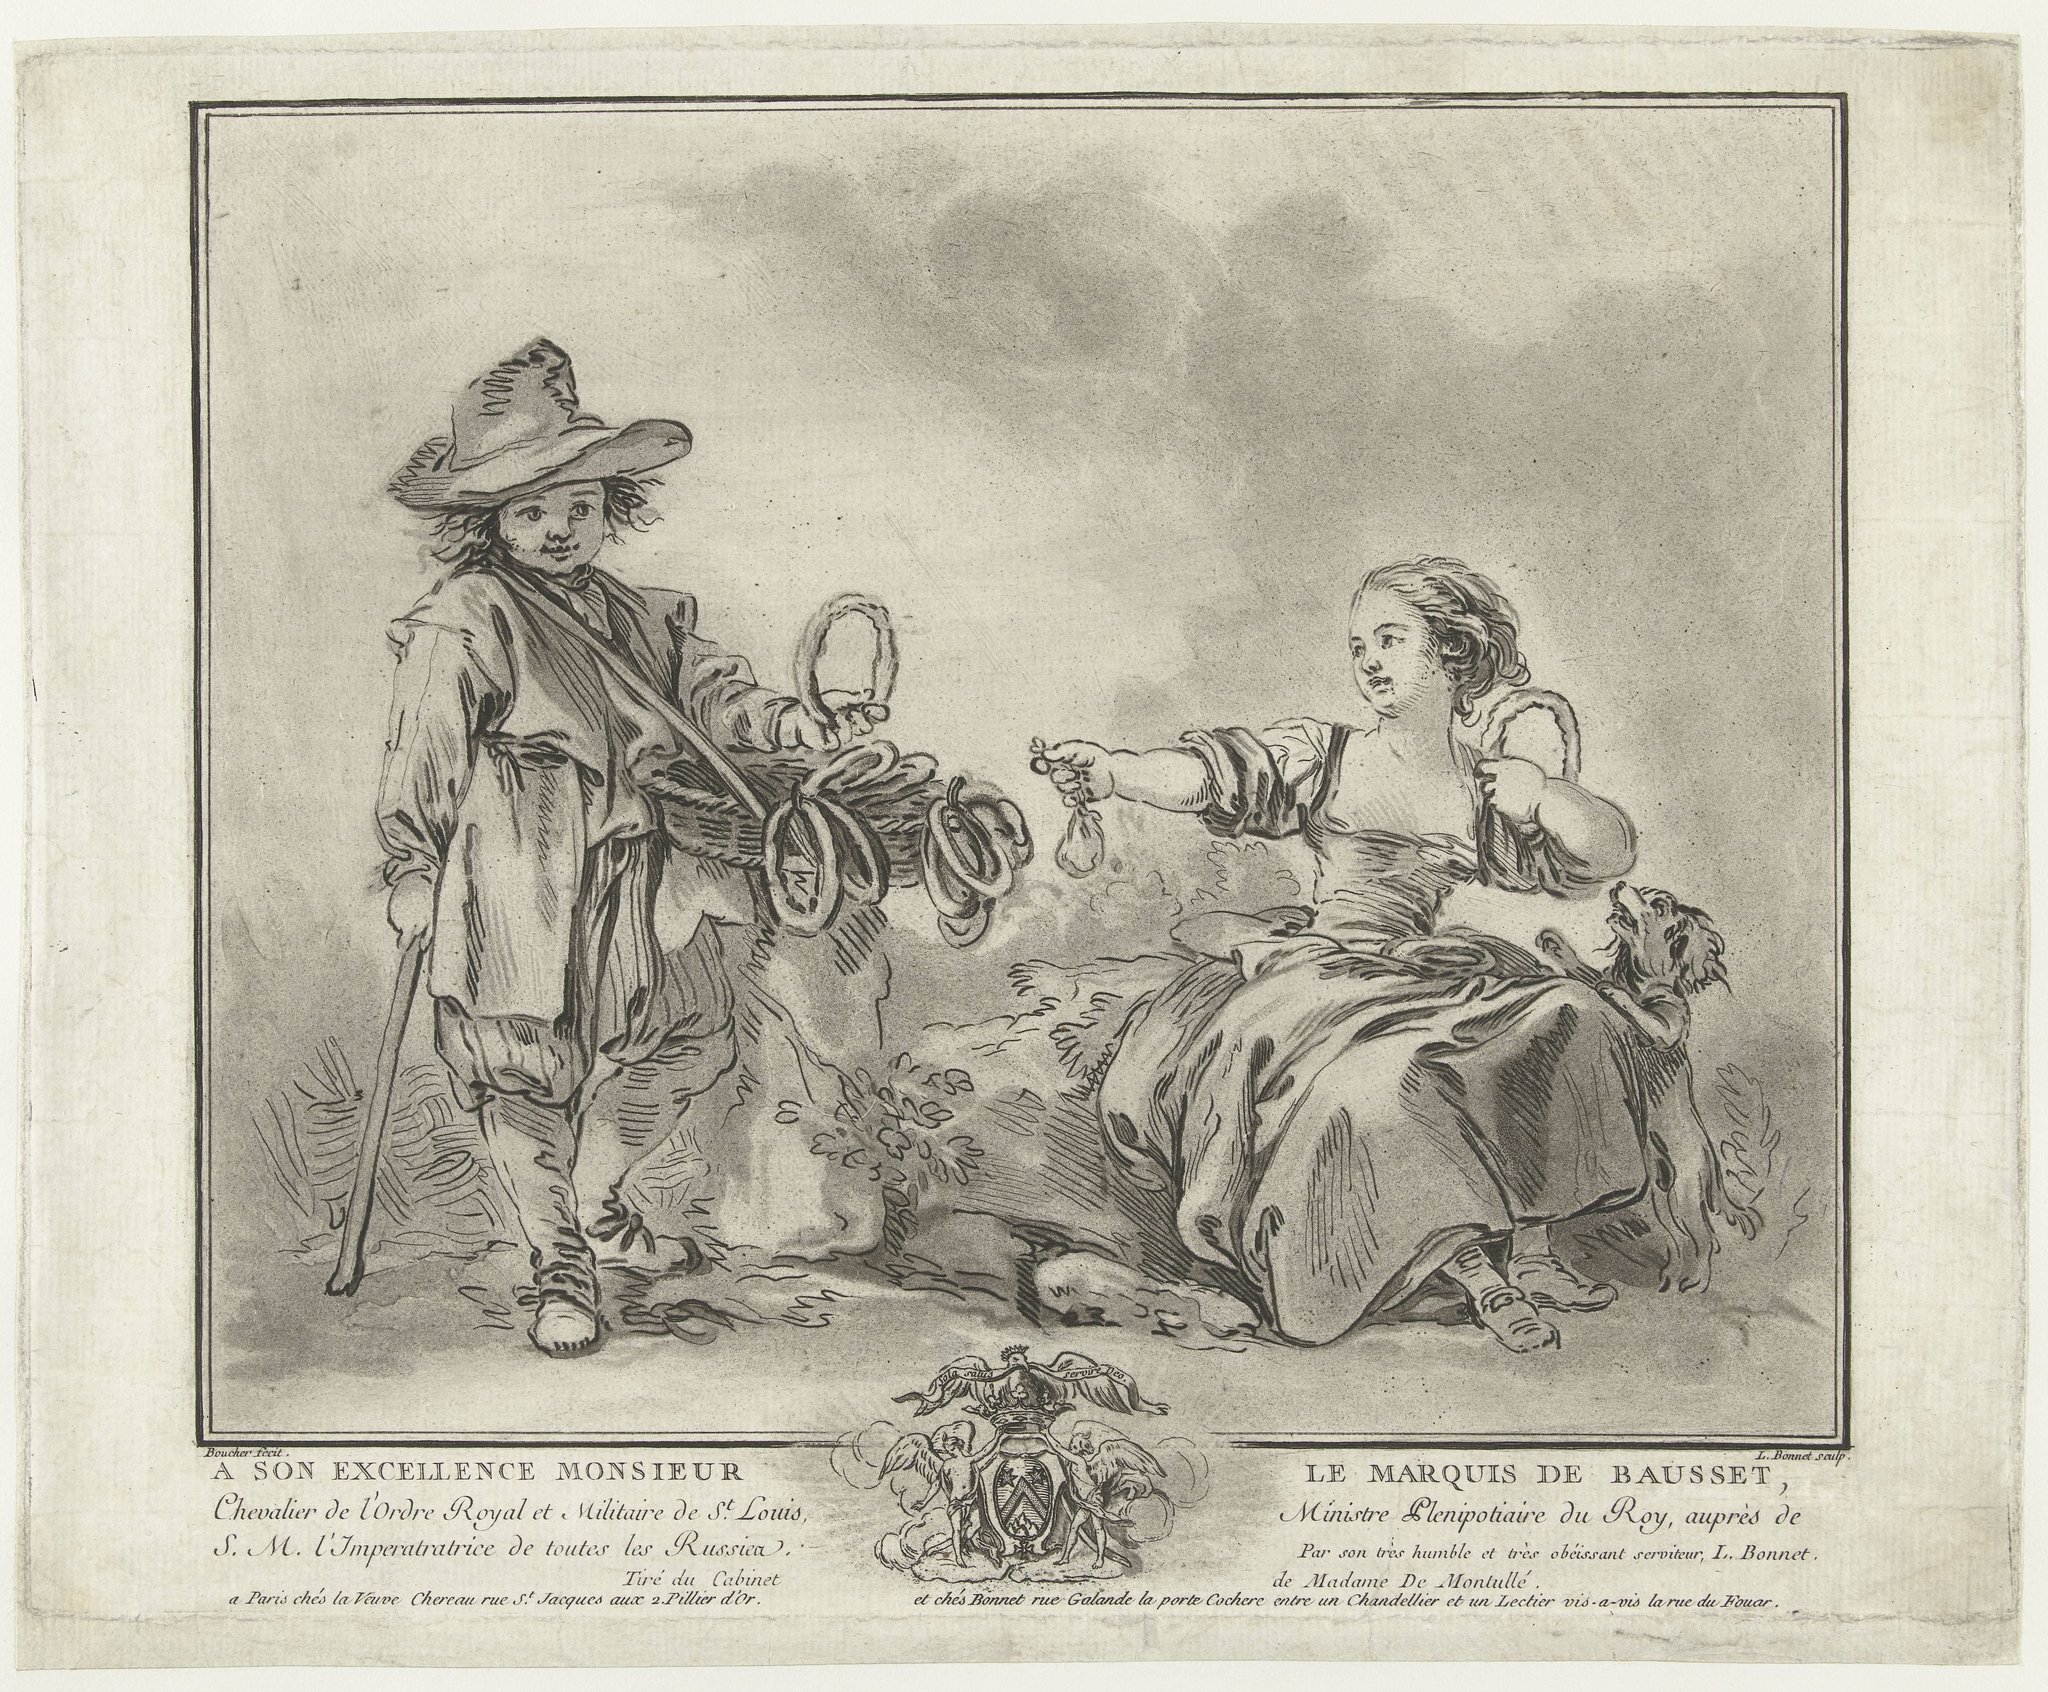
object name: print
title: Le marchand de gimblettes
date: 1757-1763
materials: paper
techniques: aquatint, etching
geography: paris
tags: street-trader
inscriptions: collector's mark: Lugt 2228, collector's mark: Lugt 2760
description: Een jongen met een mand met ronde koeken. Een meisje, zittend op een steen, een koek in haar linkerhand en een buidel met geld in haar rechter. Een klein hondje springt tegen haar op, kijkend naar de koek. Onder de voorstelling een vier regels tekst in het Frans en een wapenschild.